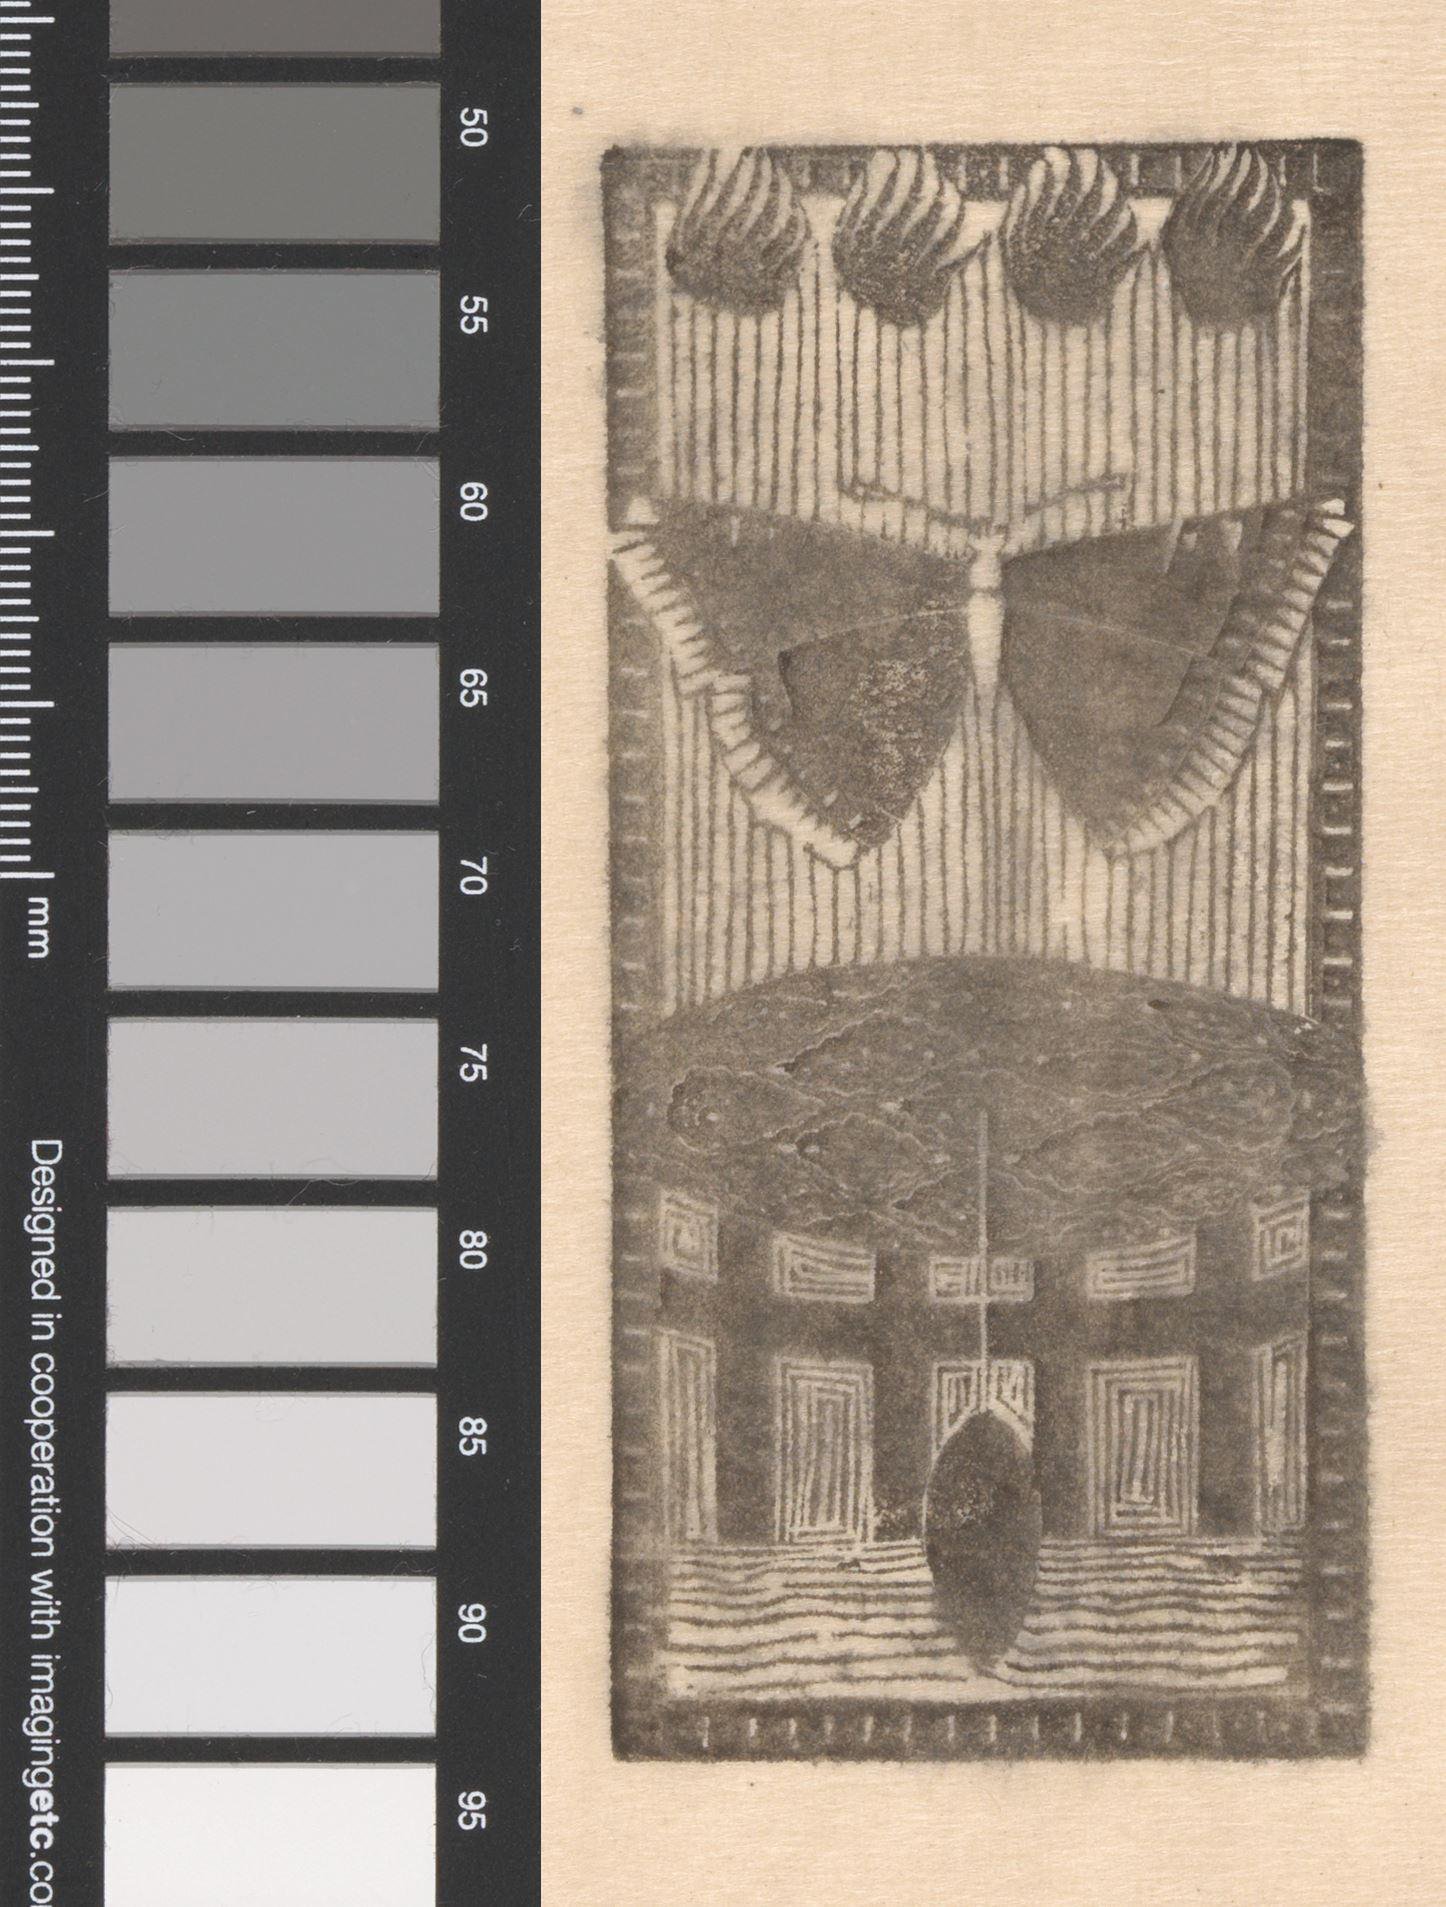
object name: illustration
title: Vlinder en vlammen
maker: mathieu lauweriks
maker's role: designer, draughtsman, print maker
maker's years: 1864-1932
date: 1895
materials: paper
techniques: woodcut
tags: holy ghost represented as flames, insects: butterfly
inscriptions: collector's mark: Lugt 2228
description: Prent mogelijk gebruikt als illustratie van het gedicht 'Geen geest in hen' in: Licht en waarheid. Orgaan van de vereeniging 'Wie Denkt Overwint'. Amsterdam: Wie Denkt Overwint, 25 mei 1895.